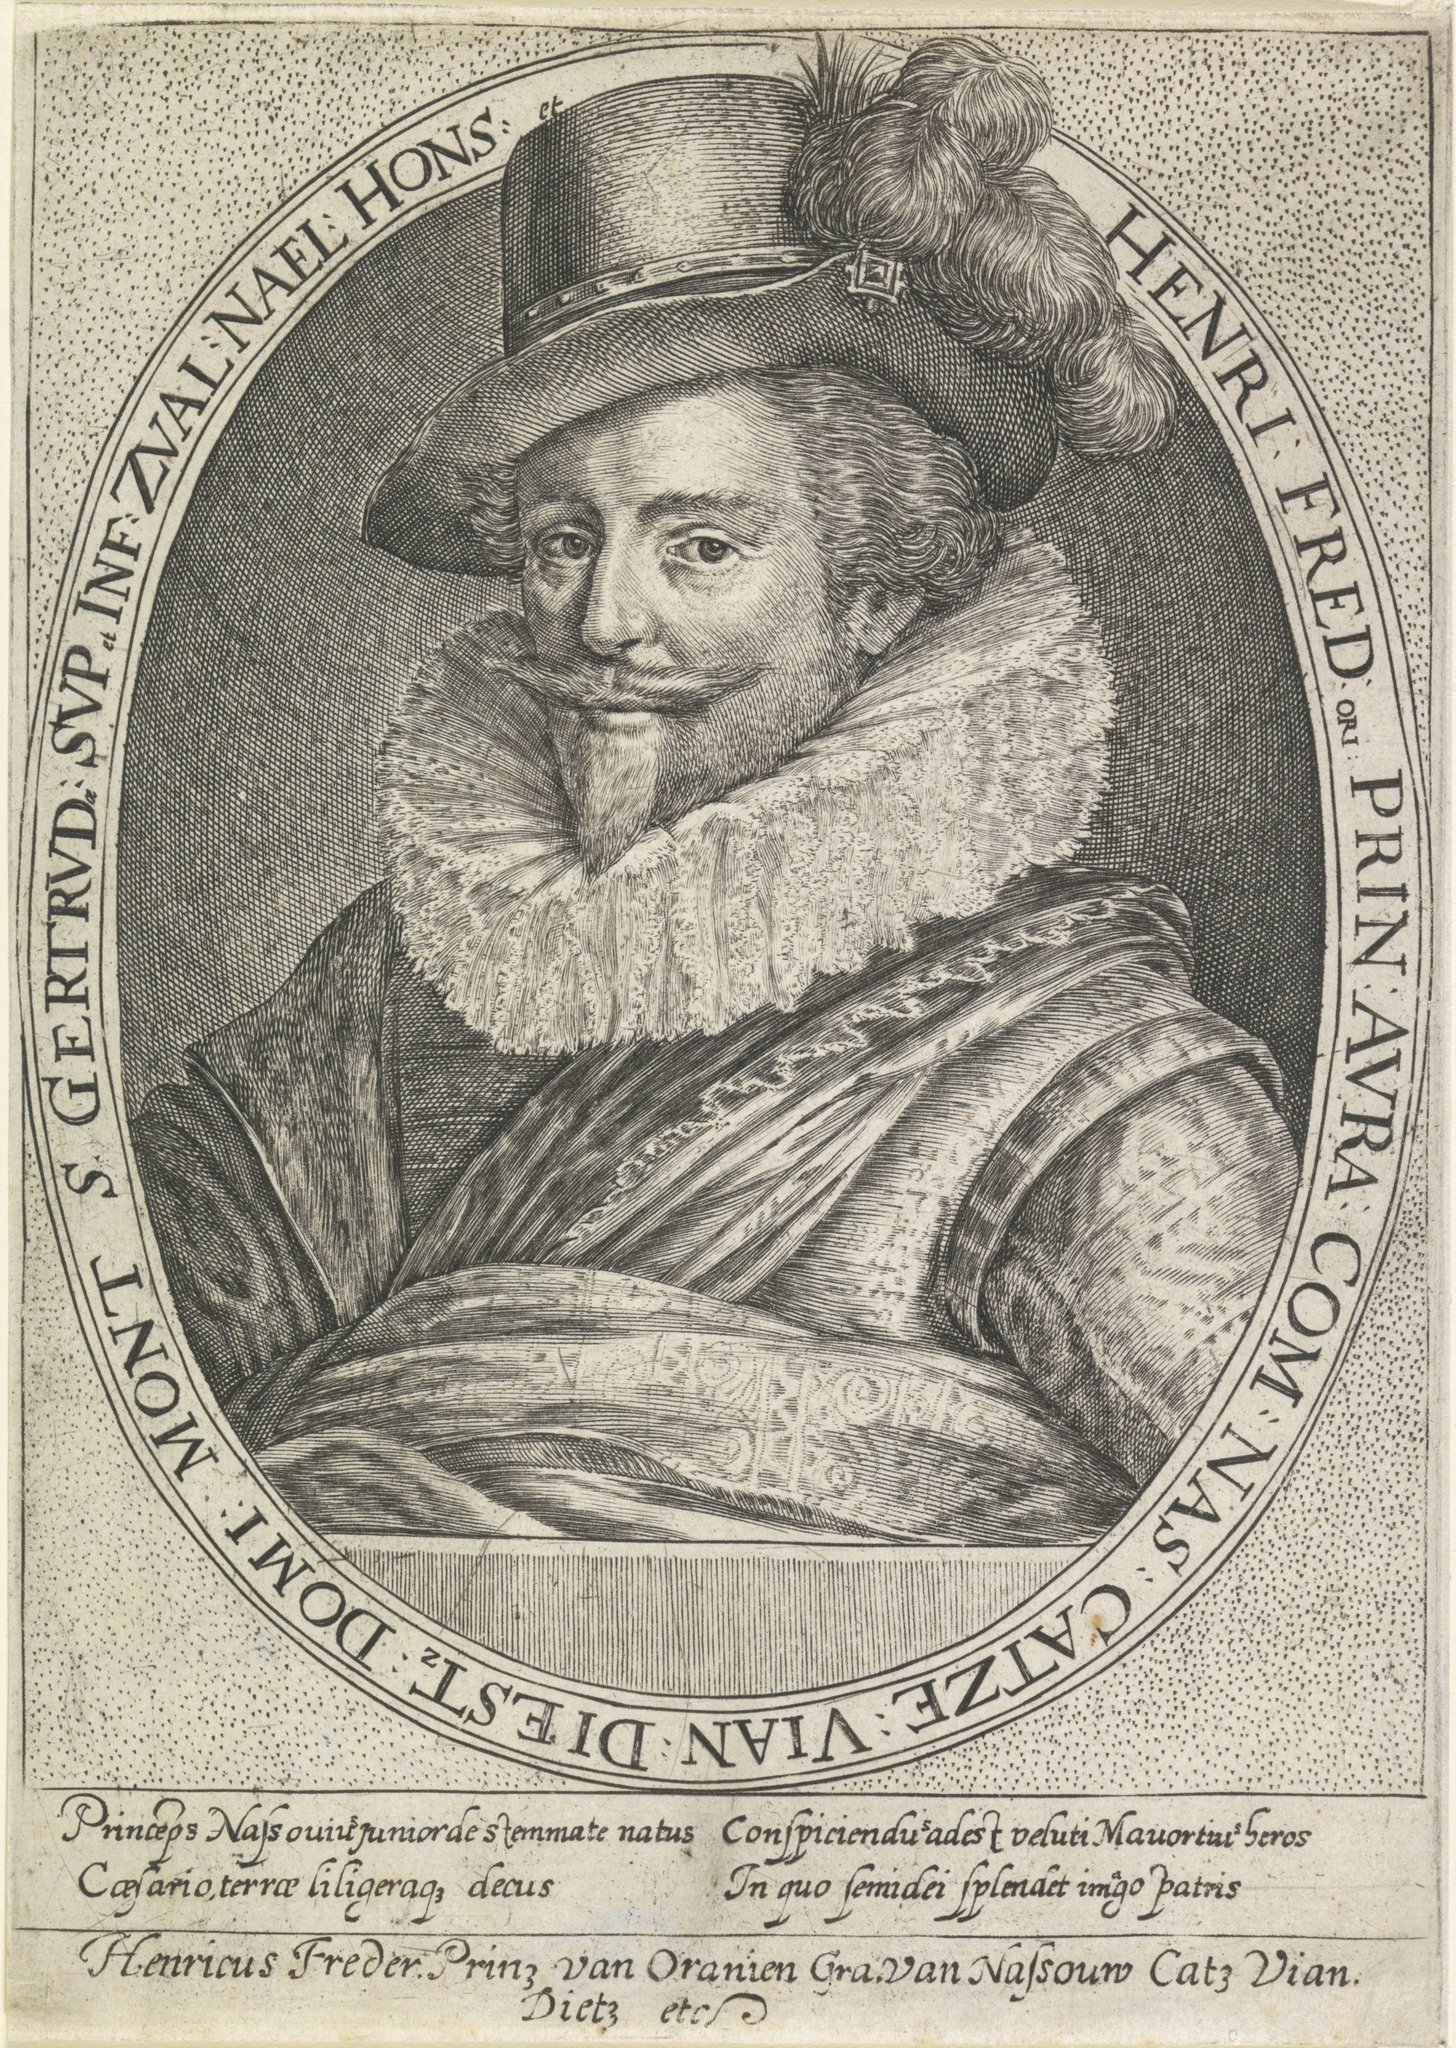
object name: print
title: Portret van Frederik Hendrik, prins van Oranje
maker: crispijn van de passe (i)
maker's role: draughtsman, print maker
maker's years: 1564-1637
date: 1580-1637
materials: paper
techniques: engraving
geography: low countries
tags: the hague, frederick henry (prince of orange)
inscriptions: collector's mark: Lugt 2228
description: De hier vermelde titel verwijst naar de hoogst verkregen titel van de geportretteerde, niet per se naar de titel die de geportretteerde op deze voorstelling draagt.